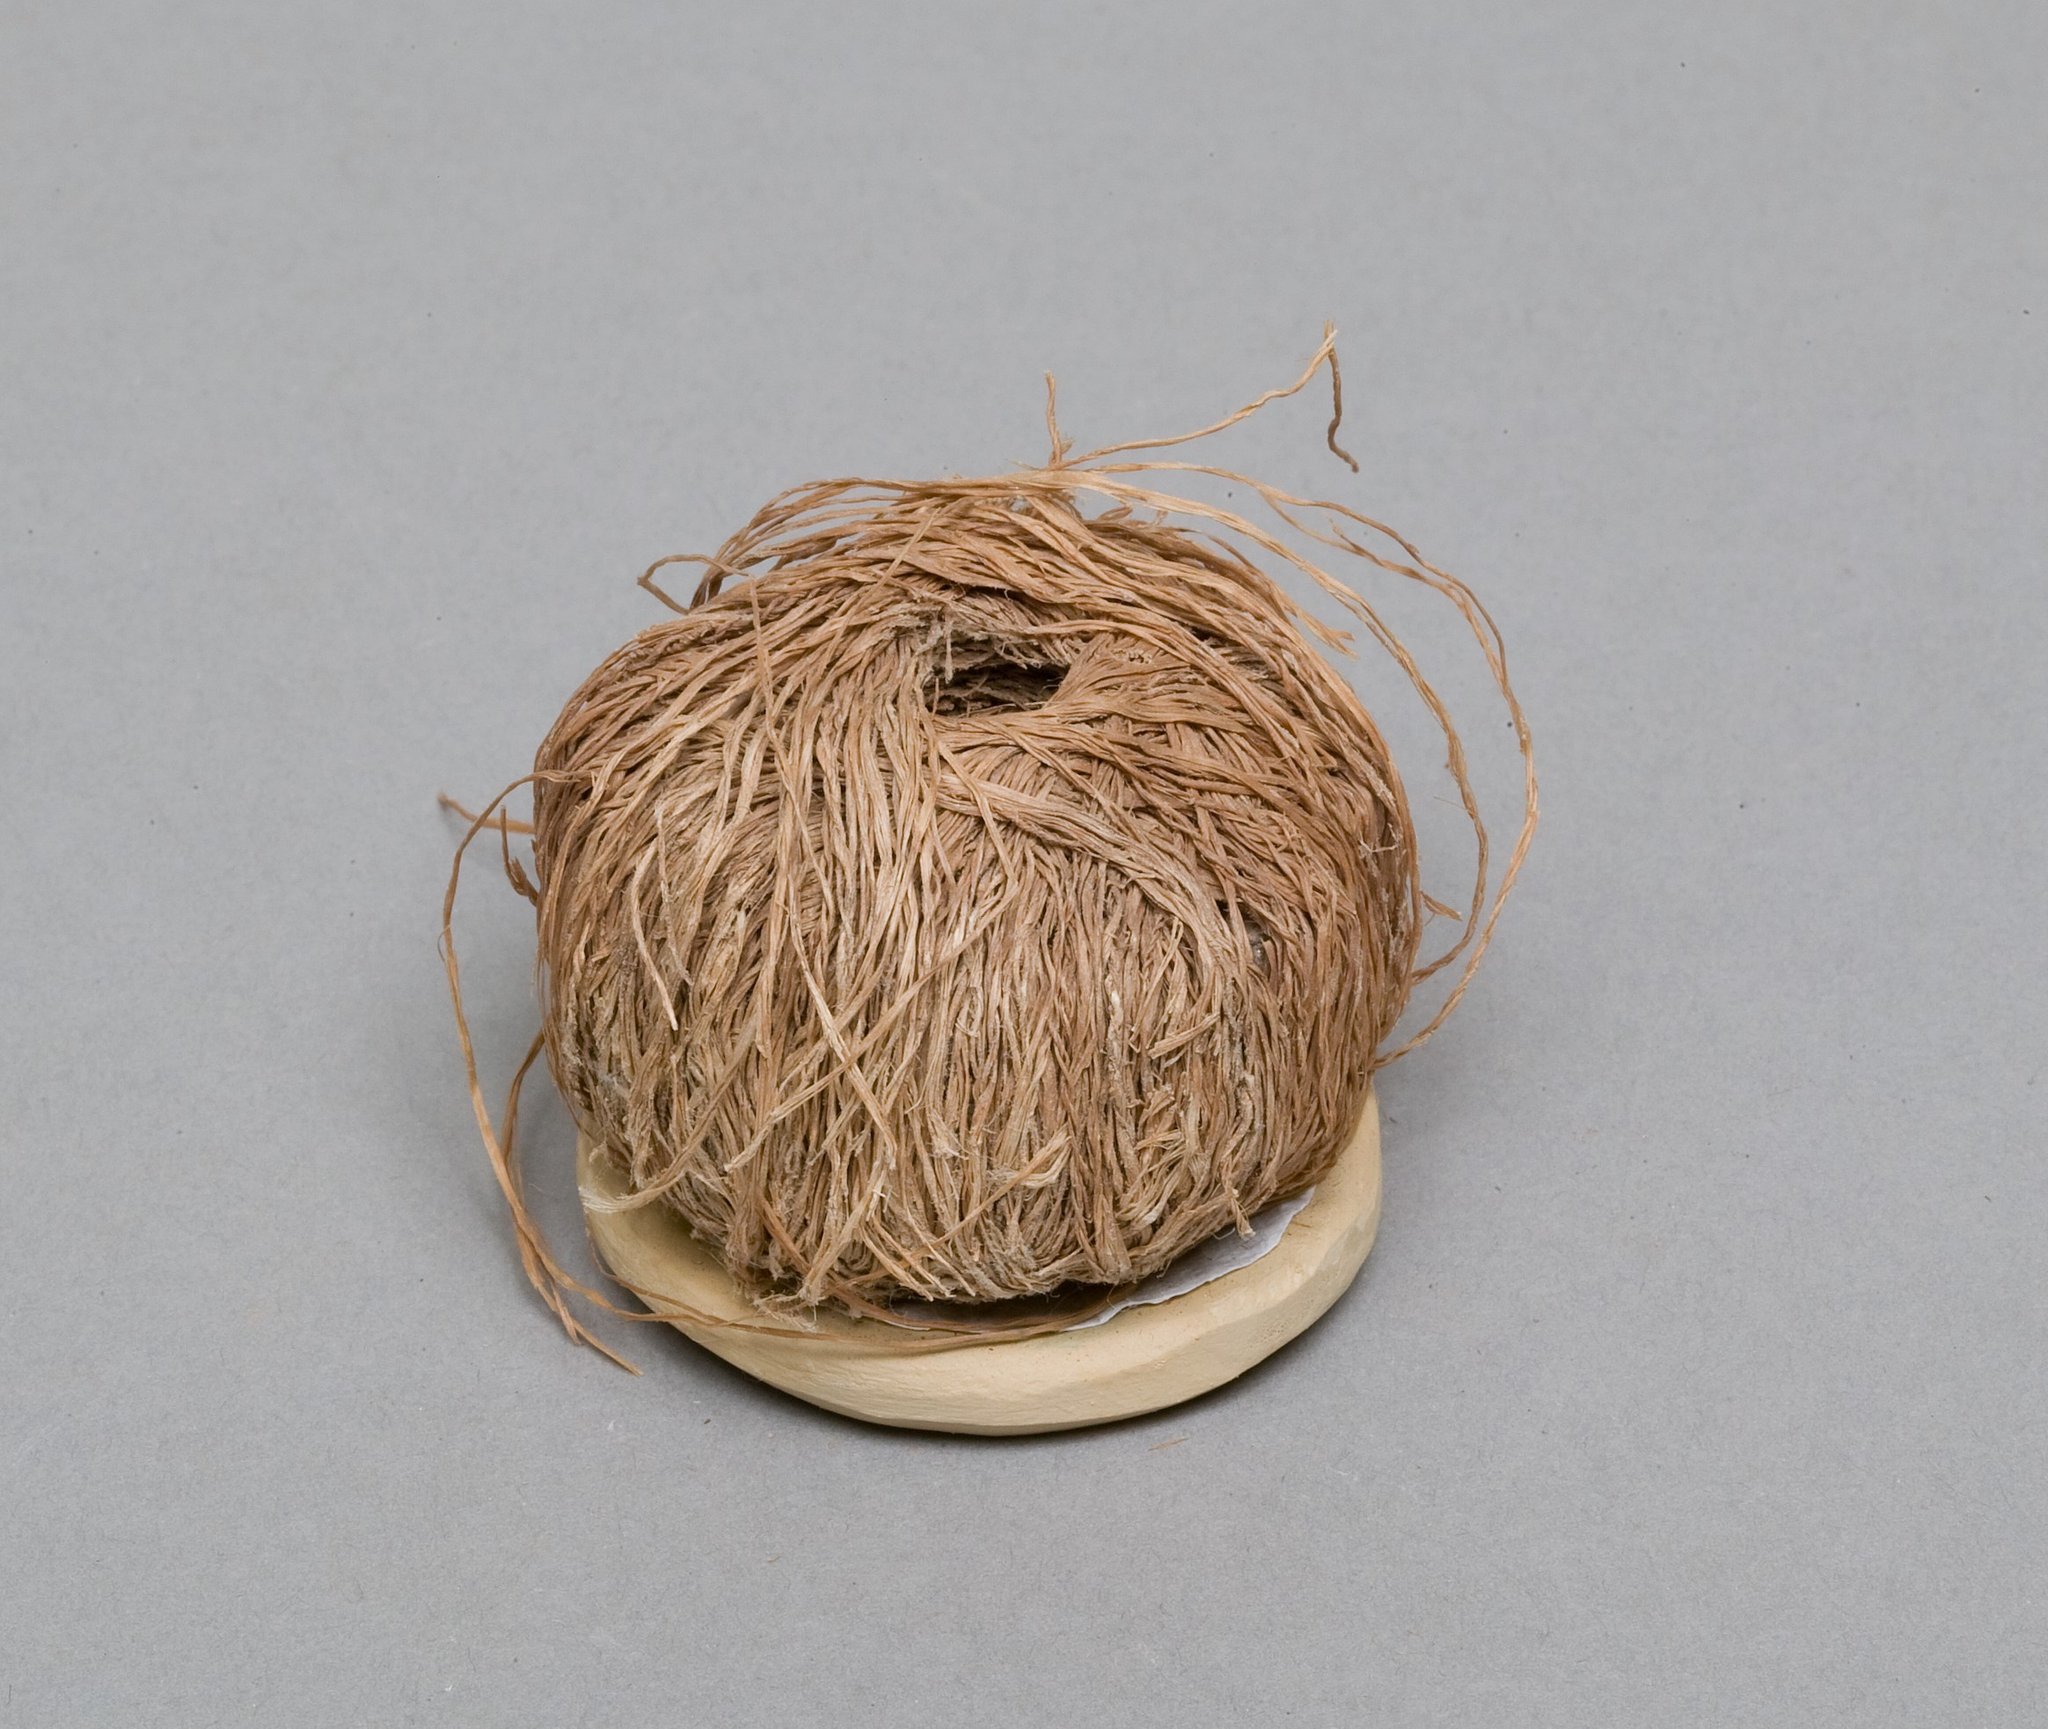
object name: ball, weaving thread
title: Ball of weaving thread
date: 1295-1070 BCE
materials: fiber, linen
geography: egypt